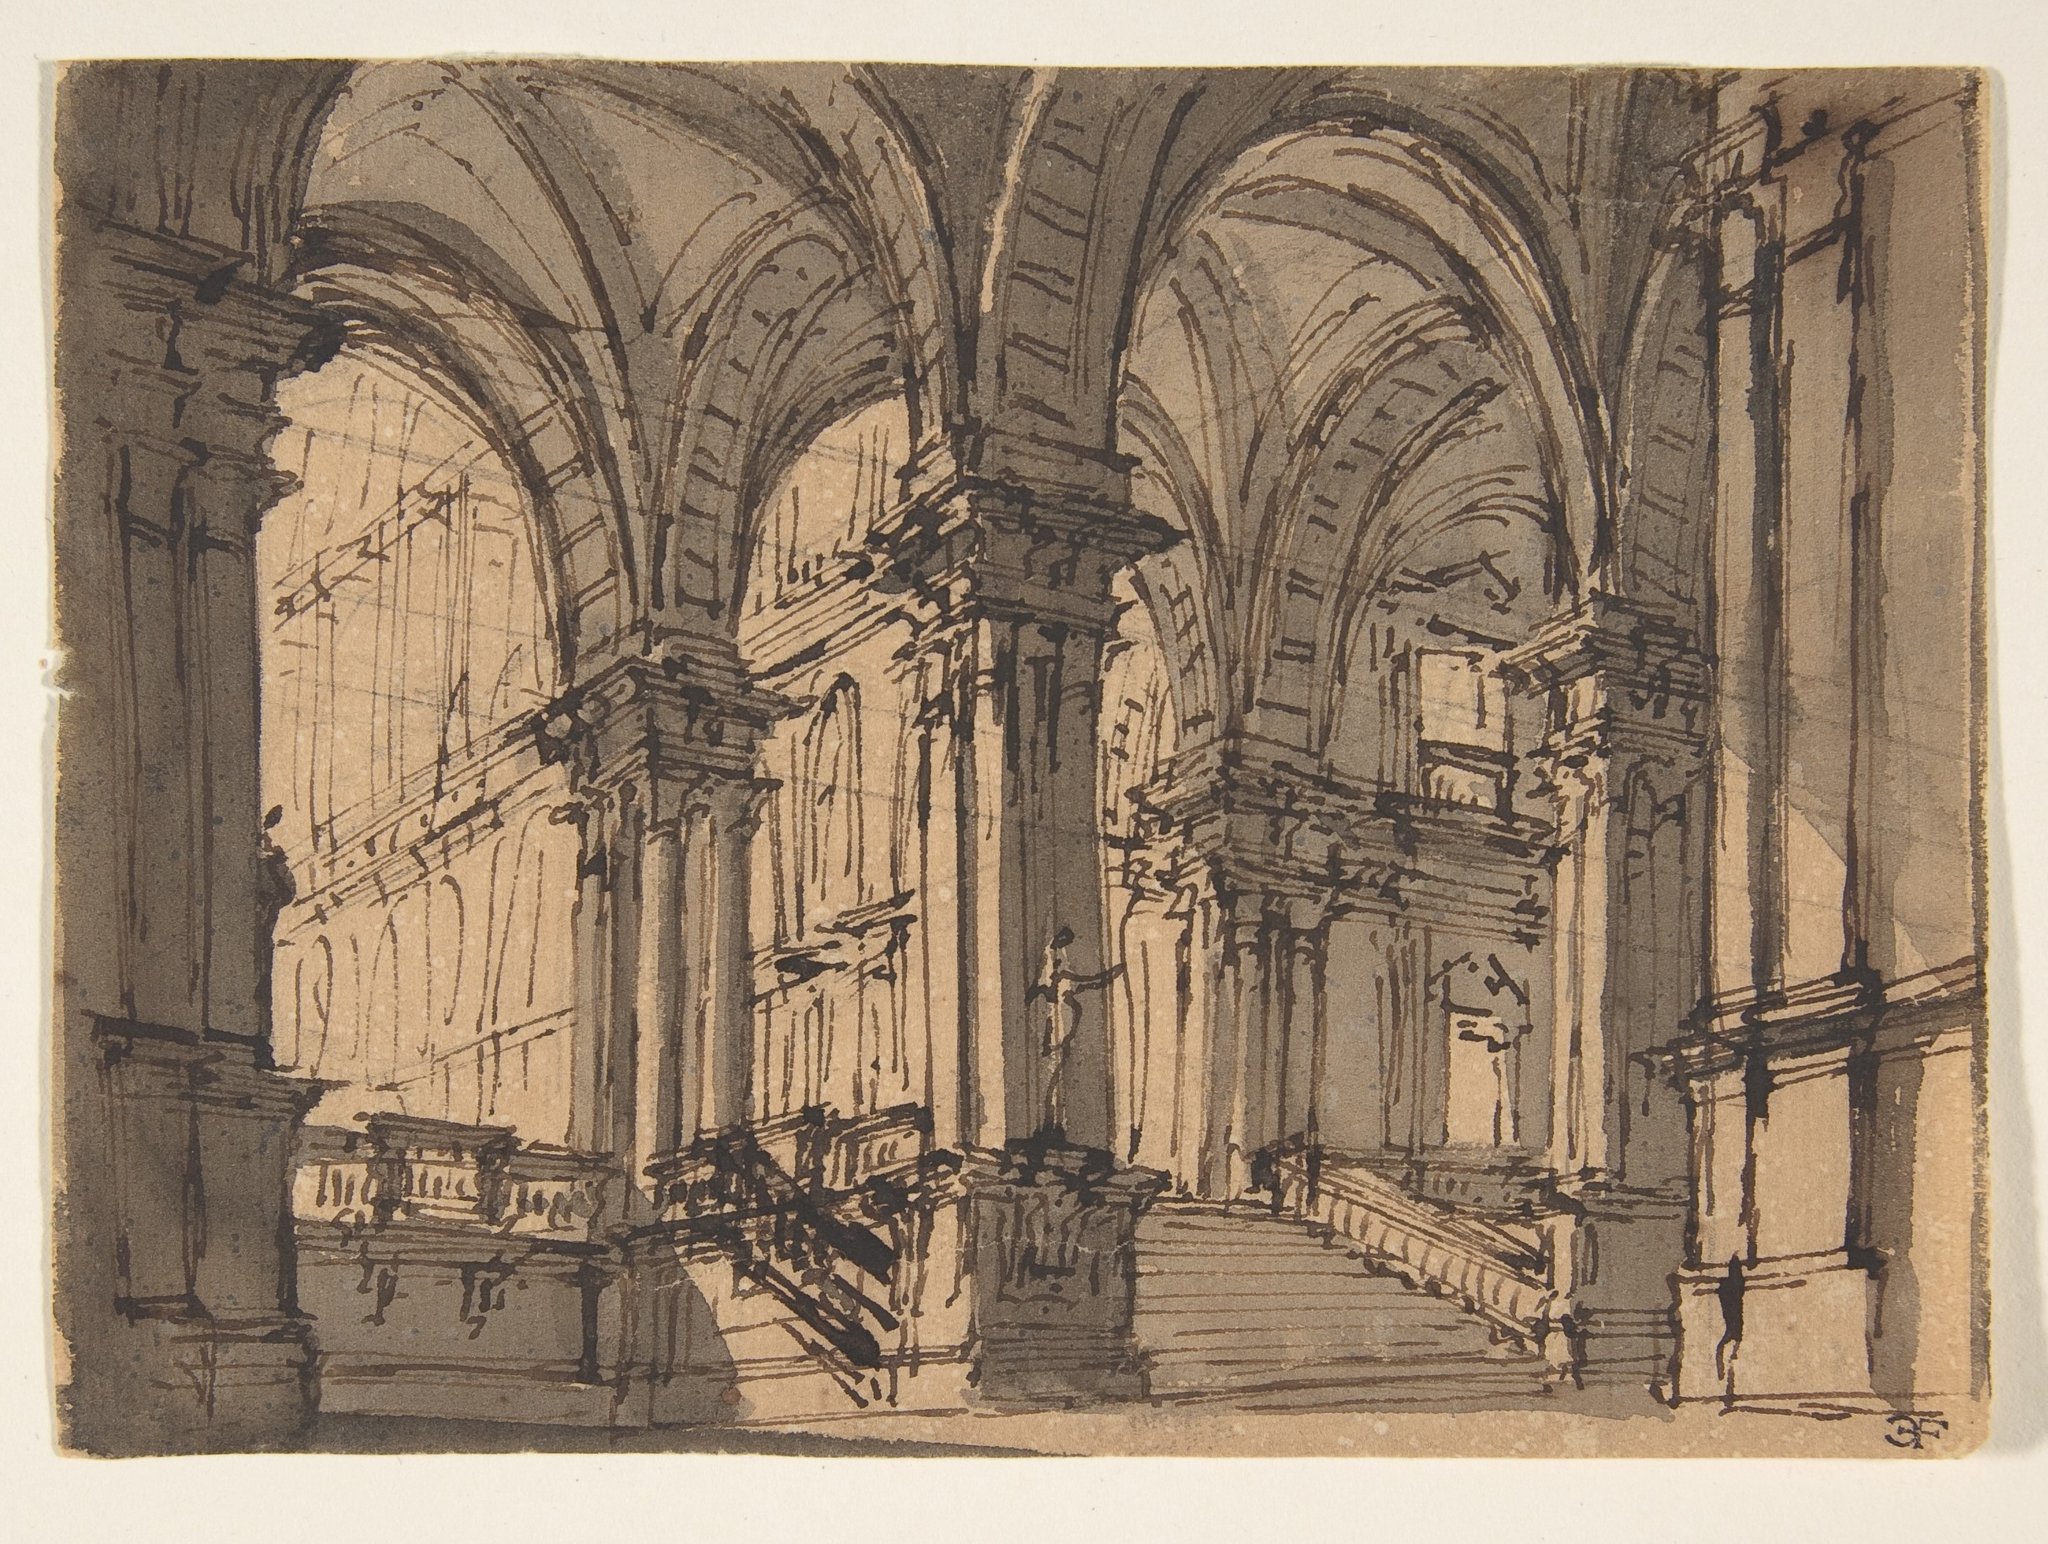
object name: drawing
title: Design for Stage Set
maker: giovanni battista natali iii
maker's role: artist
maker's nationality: italian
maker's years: 1698-1765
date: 1698-1765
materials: ink, paper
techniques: brush, pen, wash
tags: arches,stairs,stage design